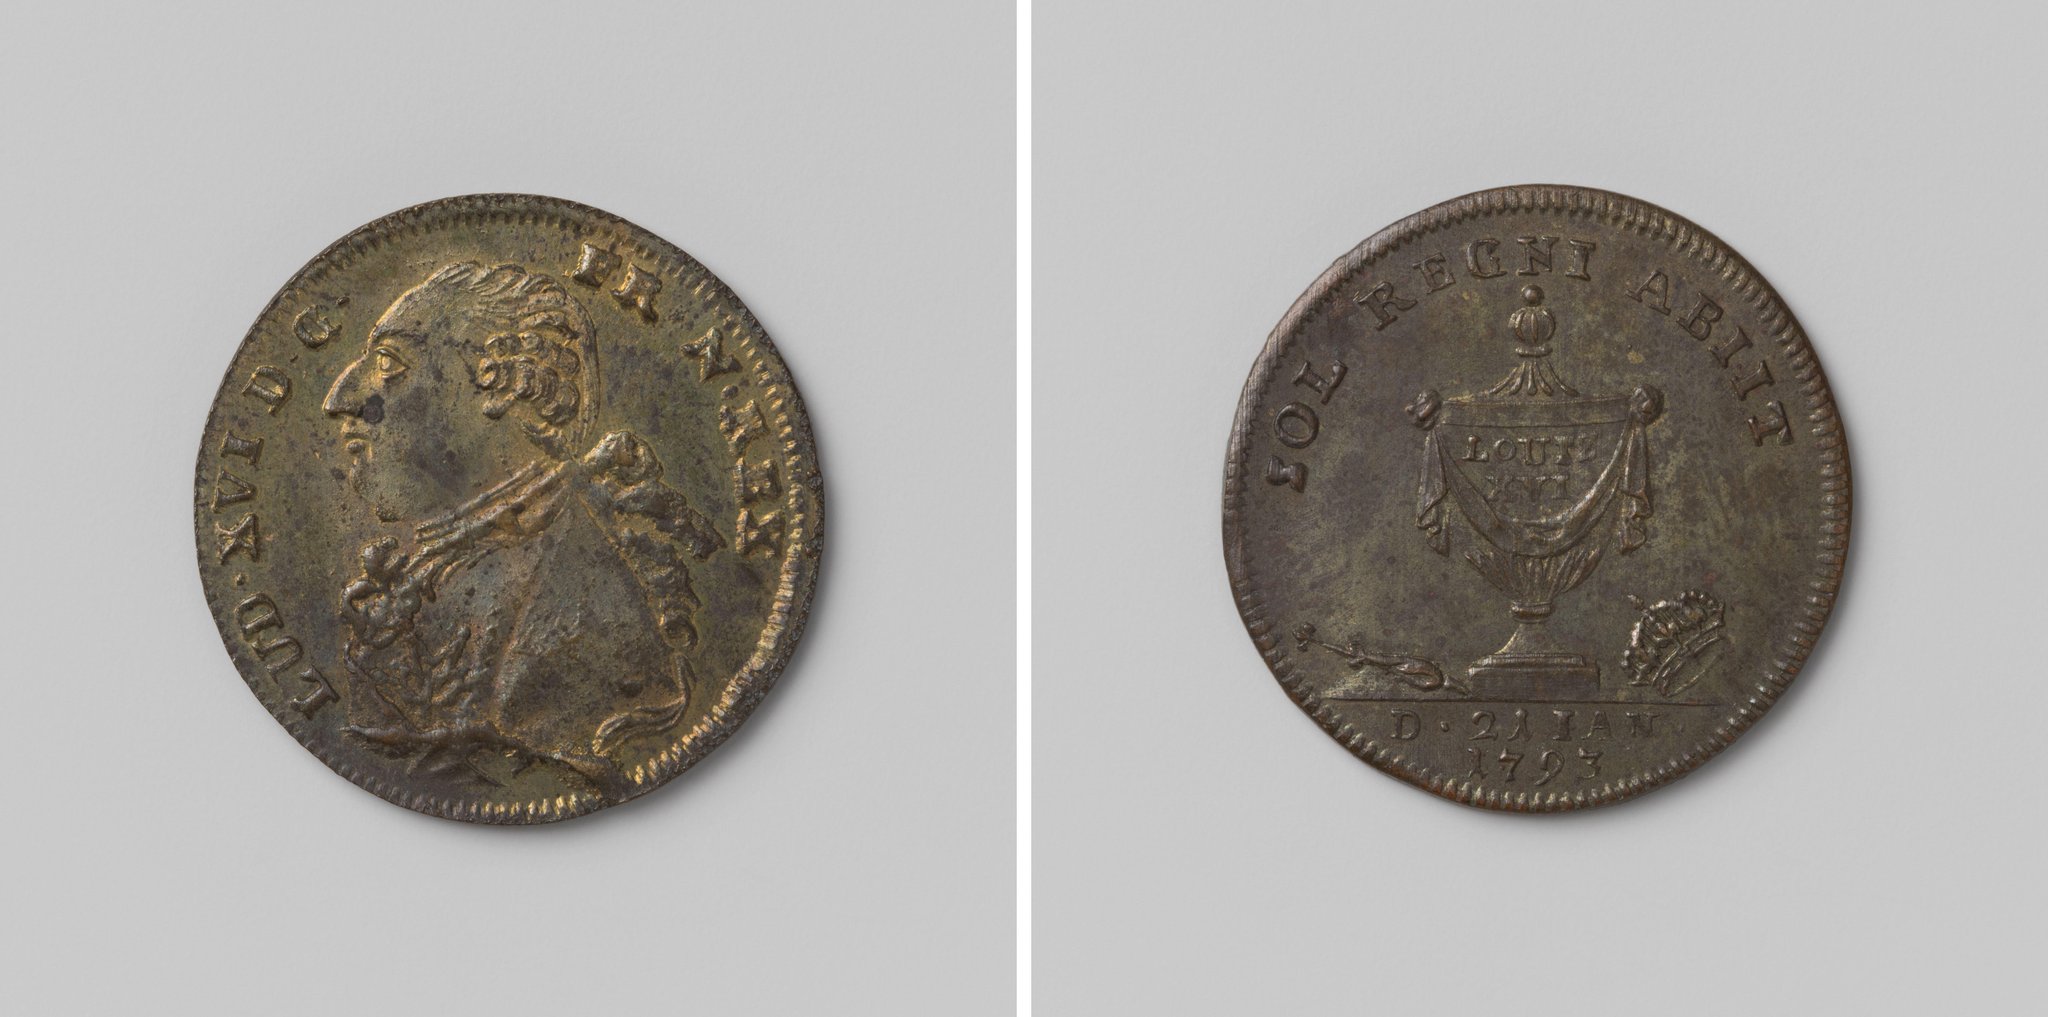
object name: jeton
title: Terechtstelling van Lodewijk XVI, koning van Frankrijk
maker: Anonymous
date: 1793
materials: brass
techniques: striking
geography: france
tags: paris, lodewijk xvi (koning van frankrijk)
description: Messing penning. Voorzijde: borststuk man binnen omschrift. Keerzijde: lijkbus met opschrift staande tussen scepter en kroon binnen omschrift; afsnede: datering